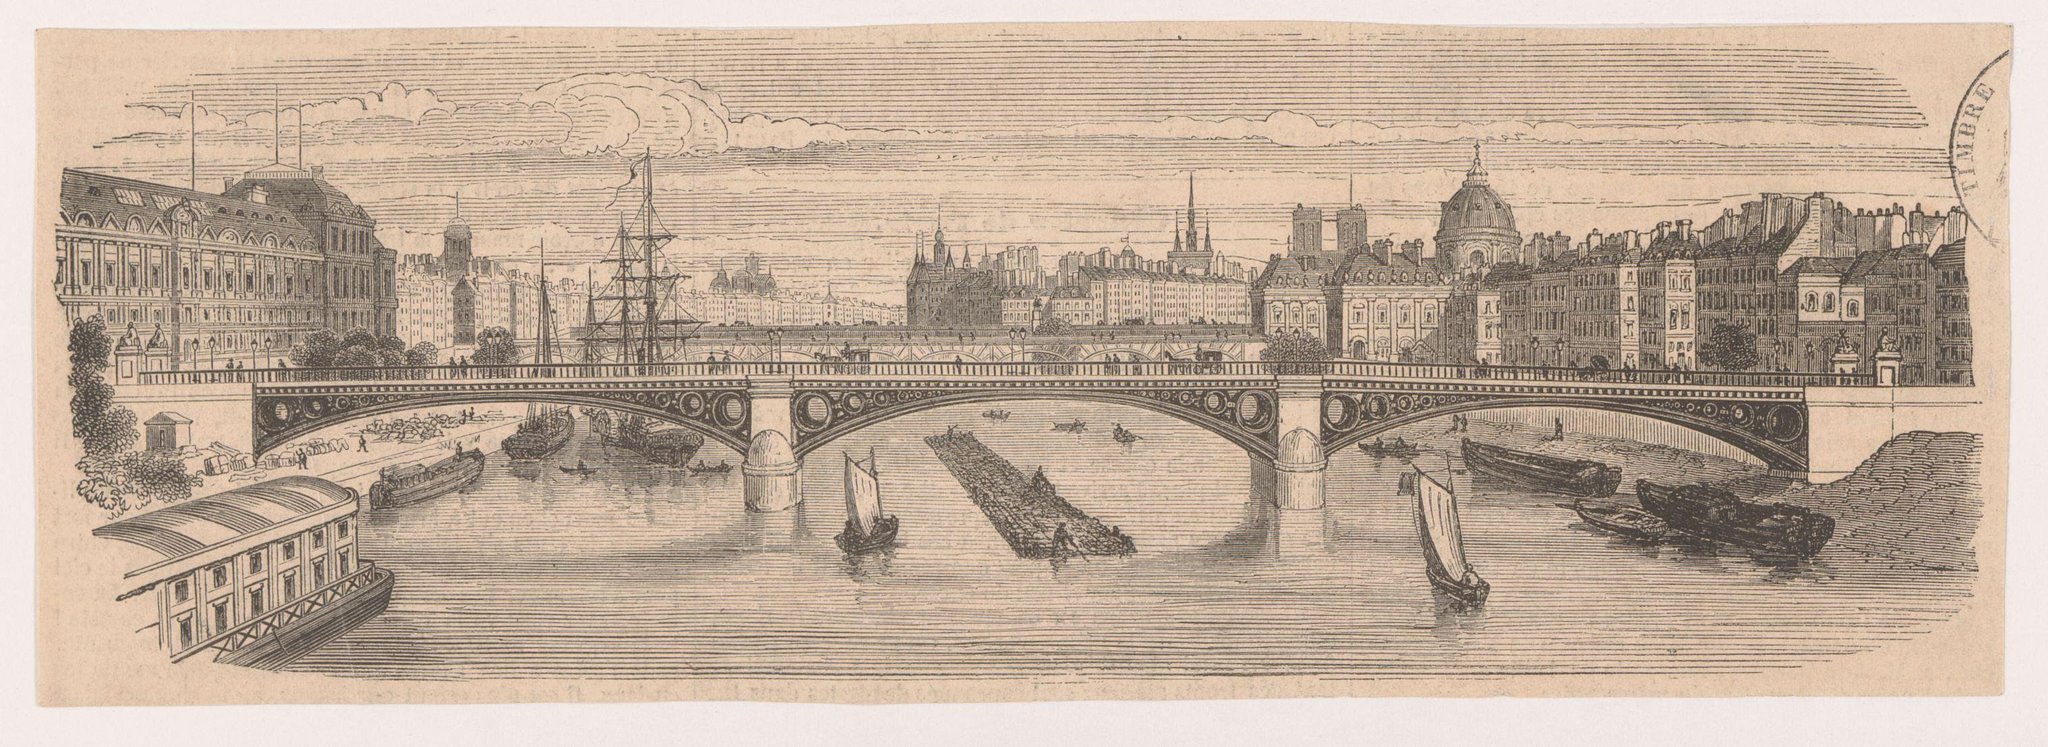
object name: print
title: Gezicht op de Seine in Parijs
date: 1856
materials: paper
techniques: letterpress printing, engraving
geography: paris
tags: canals, waters (in city) - ii - ideal city, city-view, and landscape with man-made constructions, river, canals, waters (in city), paris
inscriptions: collector's mark: ‘Timbre’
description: Prent uit: L'Illustration, vol. 28, nr. 705, 30 augustus 1856, p. 129.